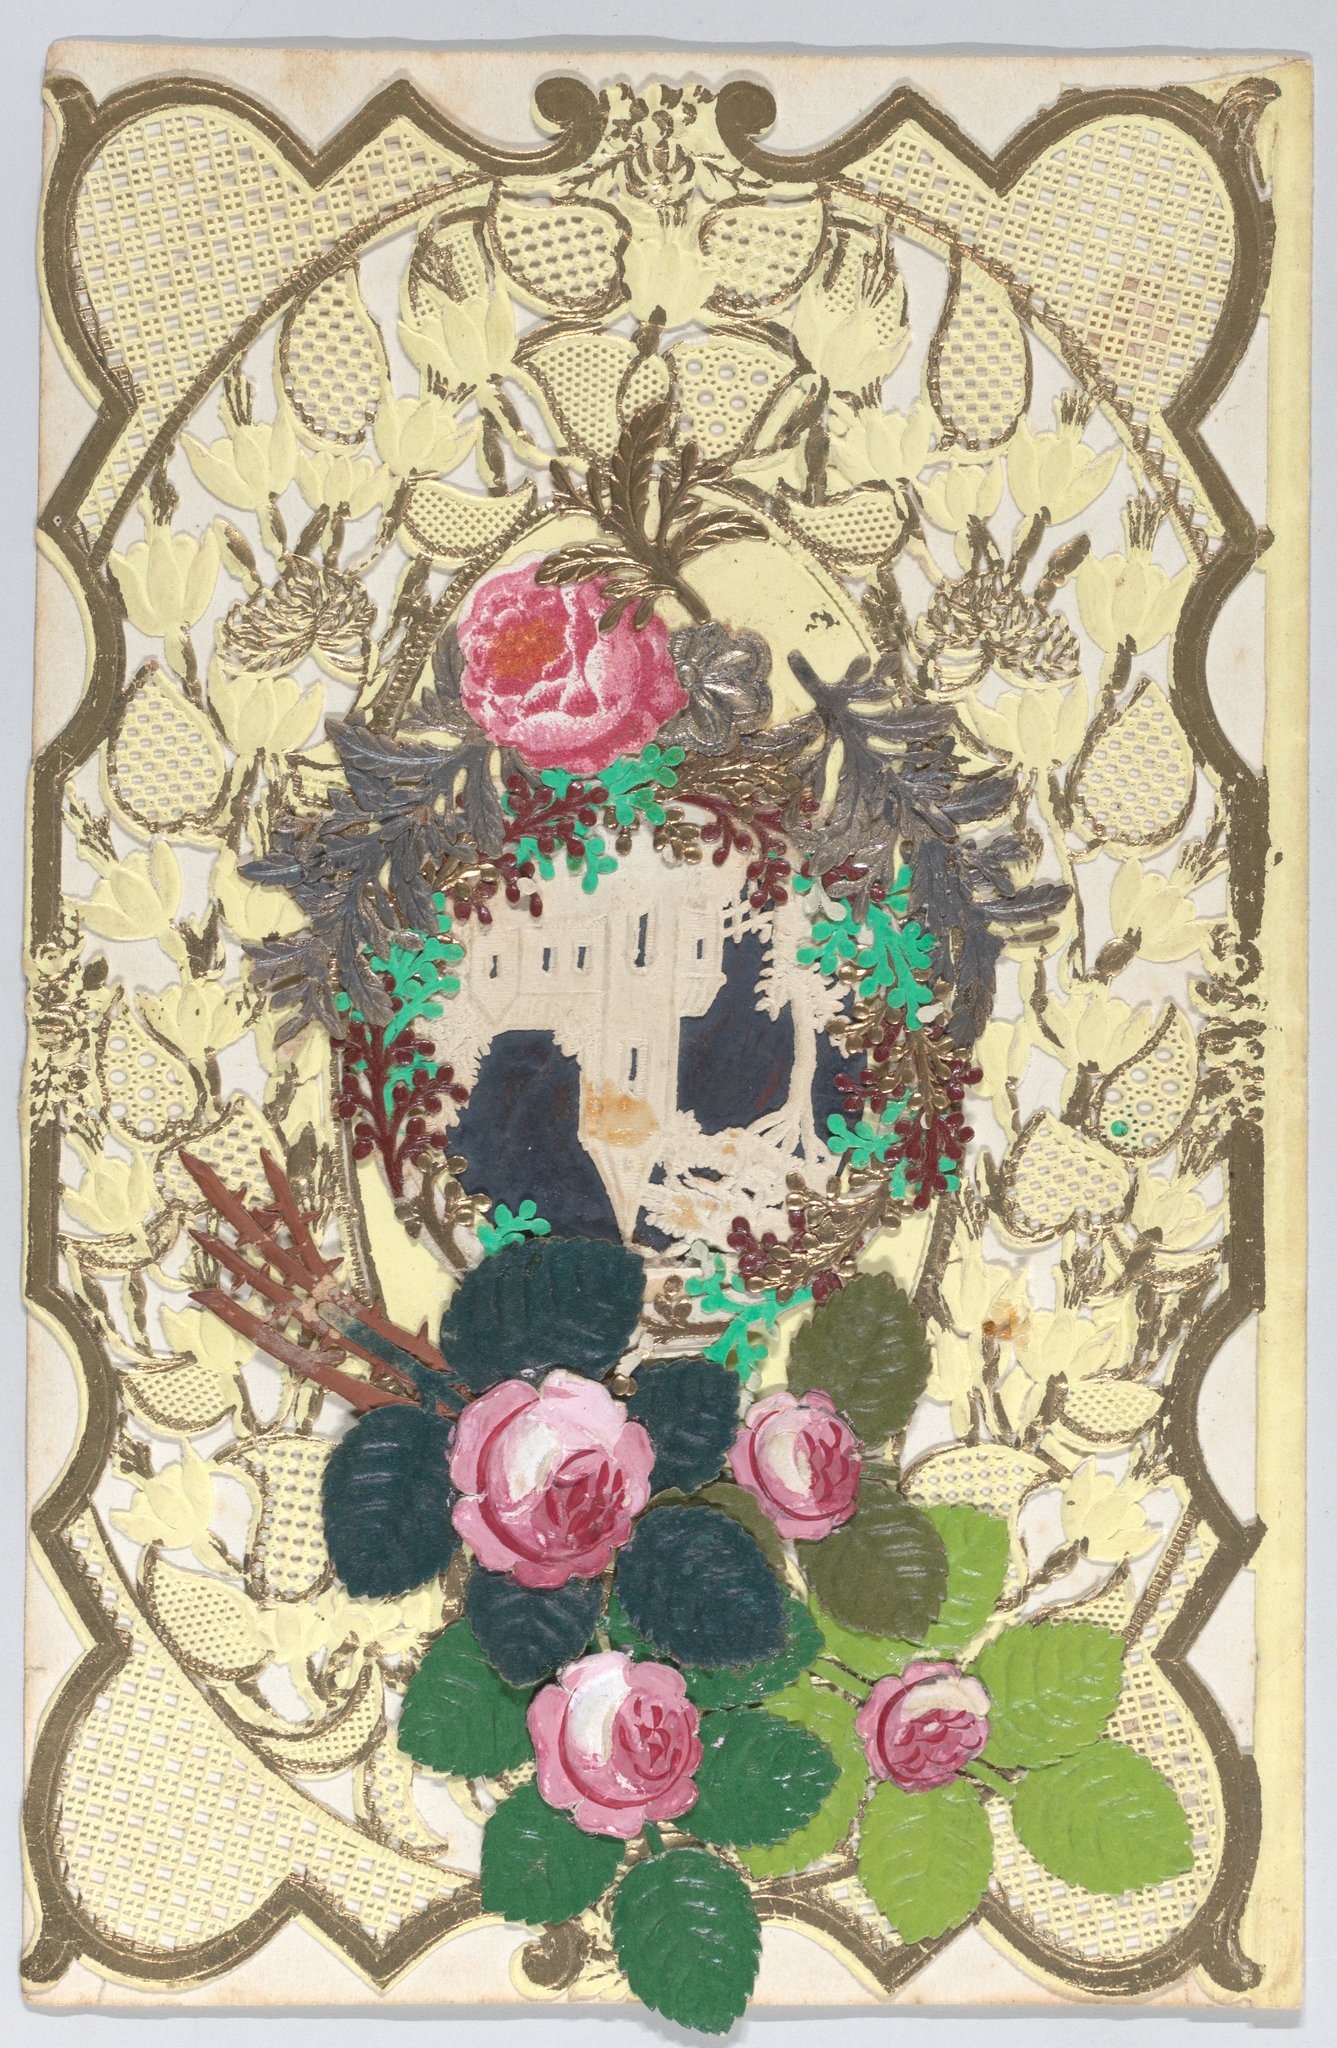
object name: valentine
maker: Anonymous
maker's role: artist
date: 1850-1860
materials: lace, paper, silver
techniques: chromolithography, cutting, embossing, gilding, open work